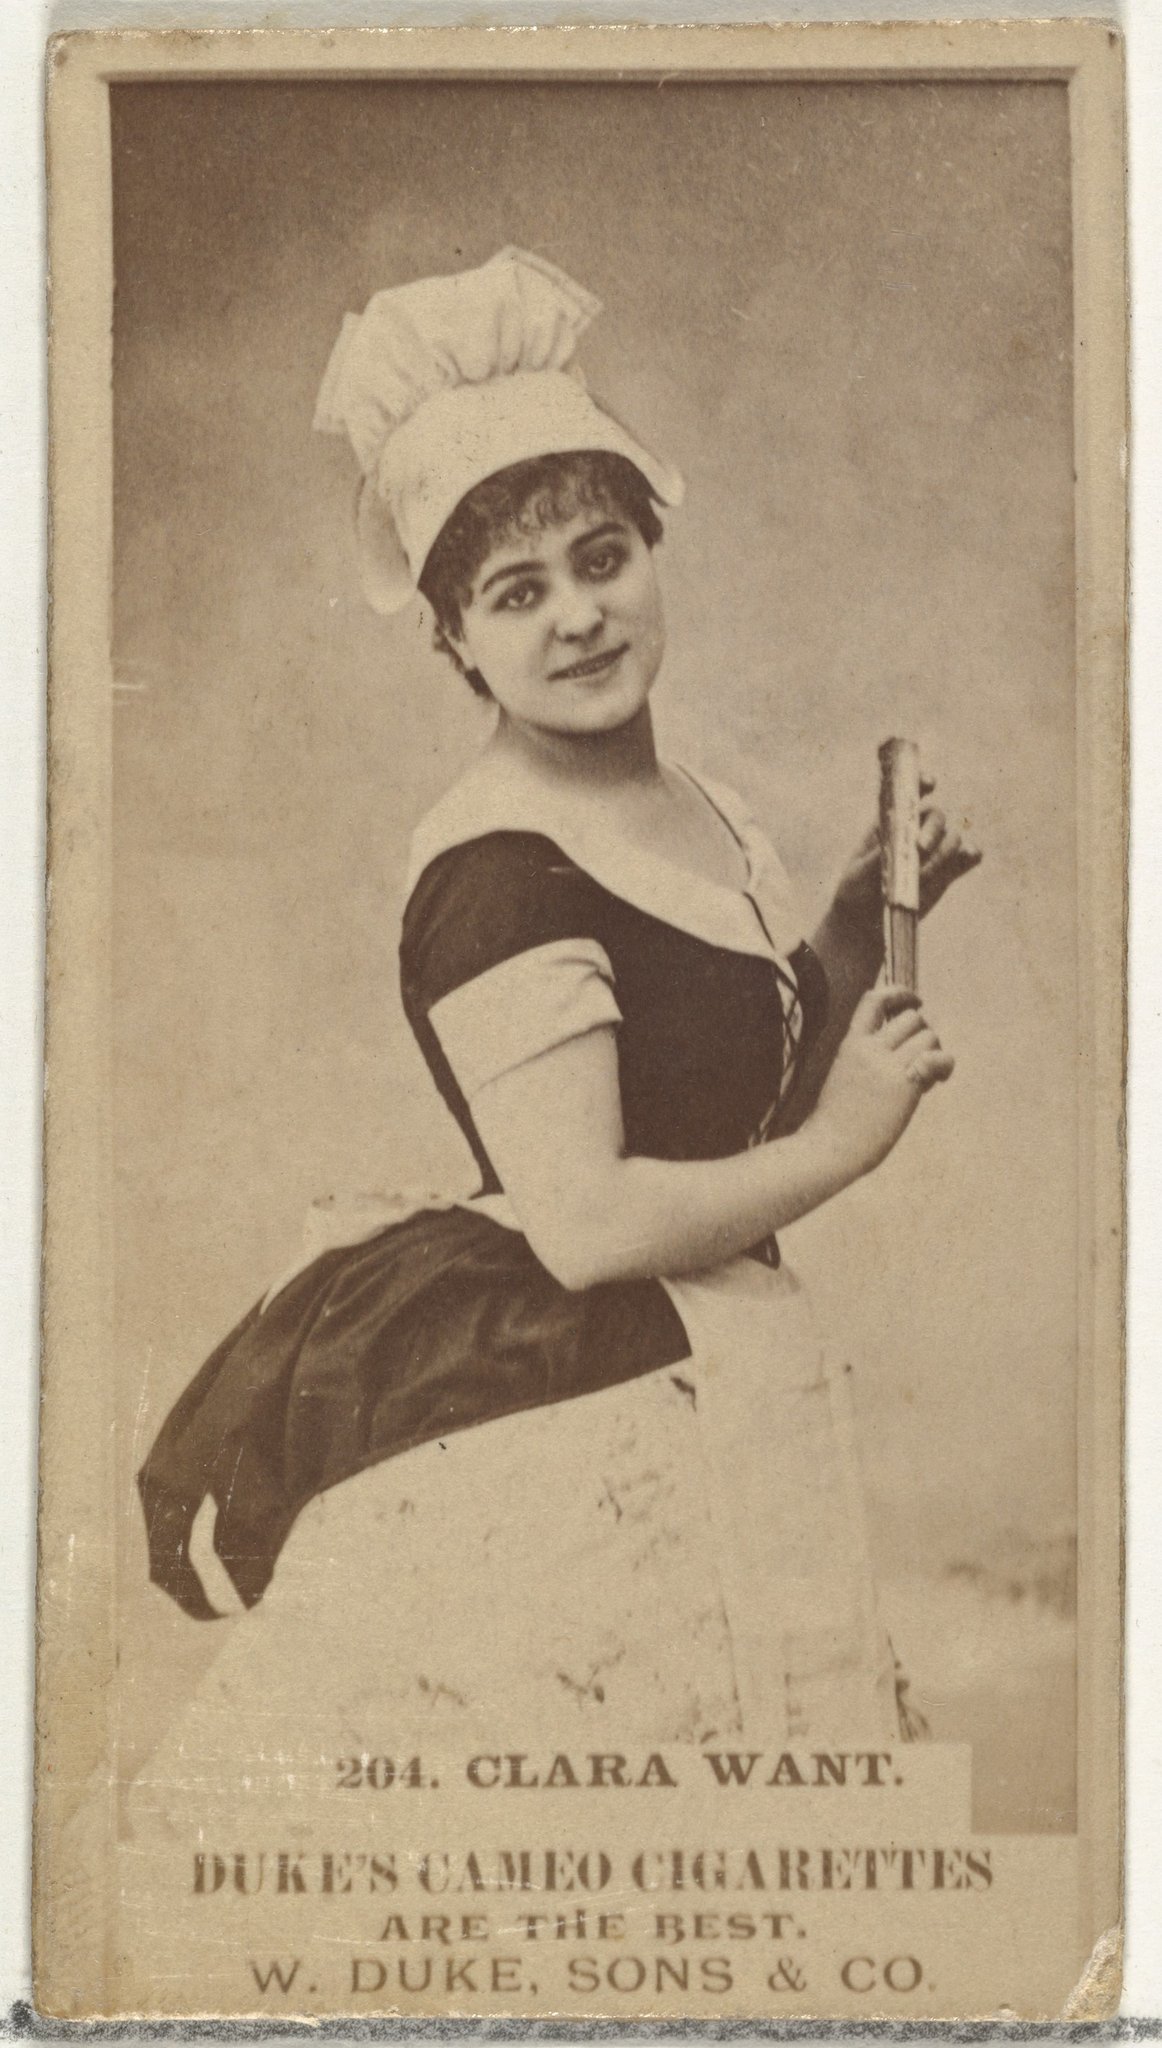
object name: photograph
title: Card Number 204, Clara Want, from the Actors and Actresses series (N145-5) issued by Duke Sons & Co. to promote Cameo Cigarettes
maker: w. duke, sons & co.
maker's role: publisher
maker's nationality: american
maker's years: 1870-1920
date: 1880-1889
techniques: albumen silver print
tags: portraits,women,actresses